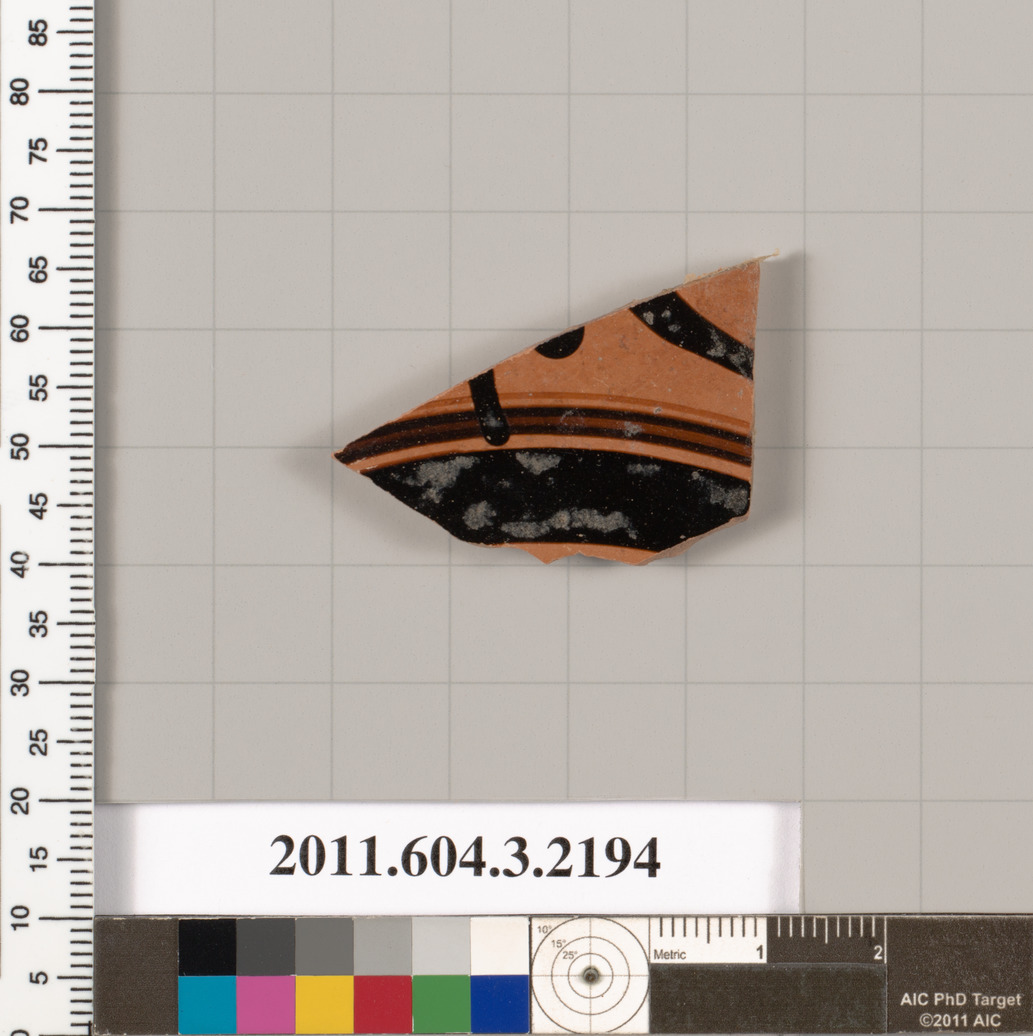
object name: kylix fragment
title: Terracotta fragment of a kylix (drinking cup)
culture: greek, attic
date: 534-468 BCE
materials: terracotta